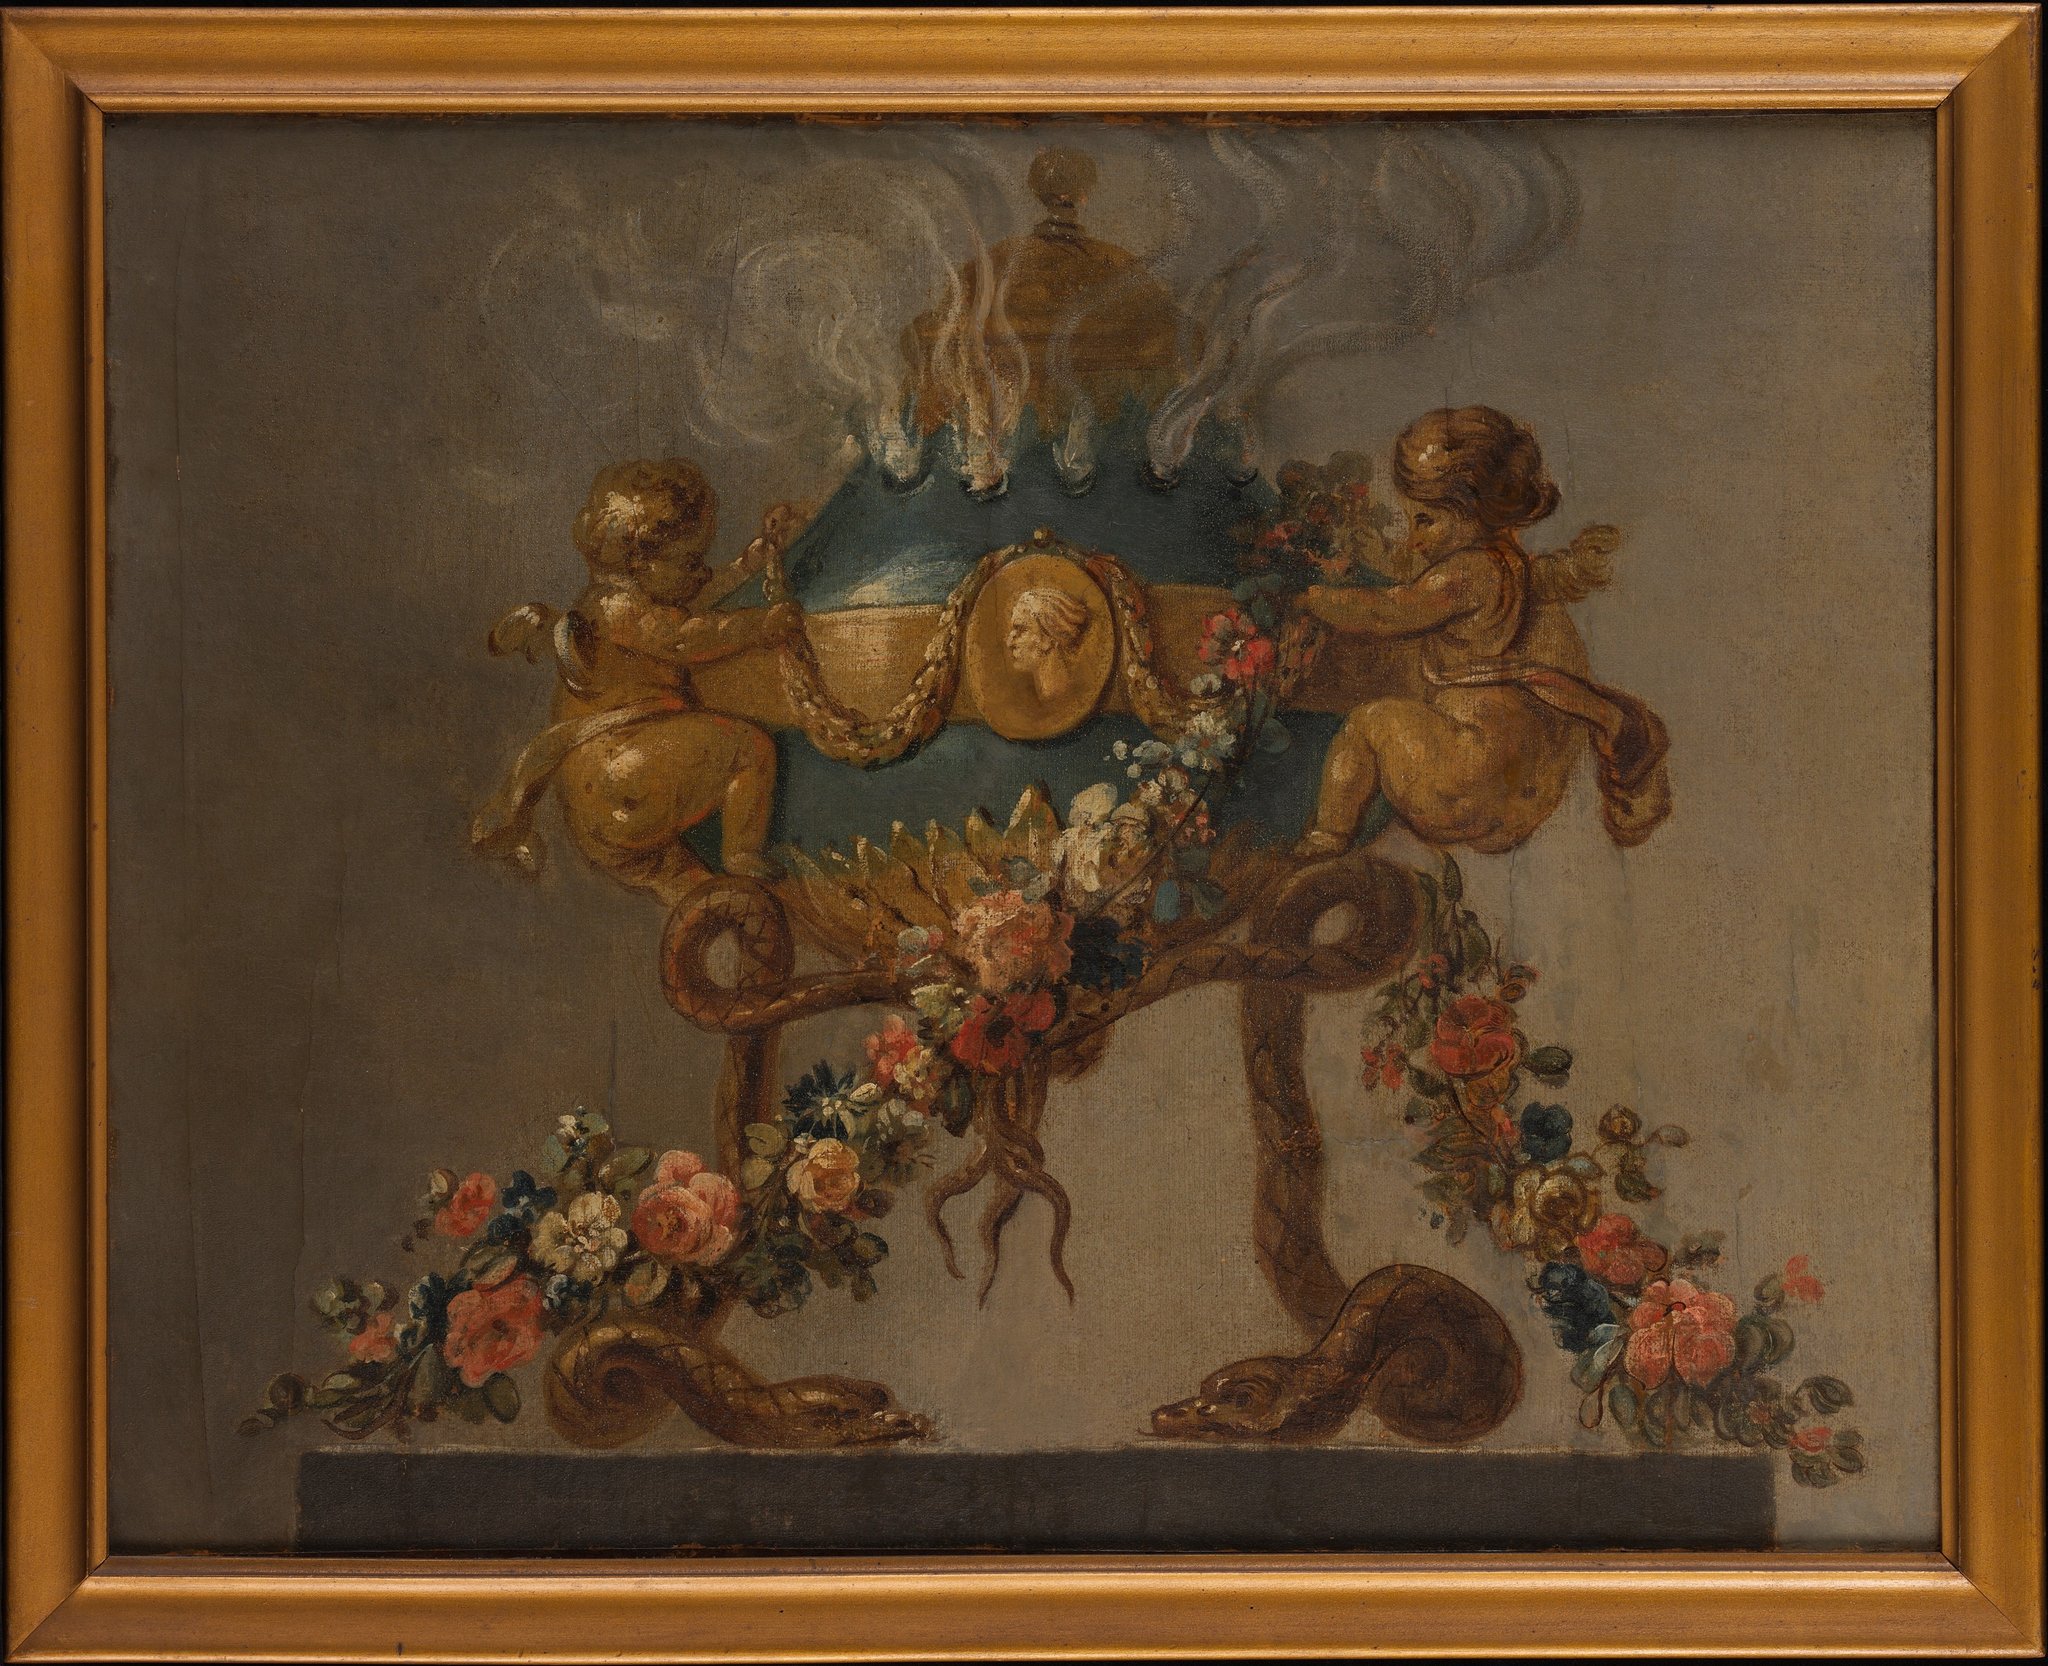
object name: overdoor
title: Perfume-burner supported by amorini and serpents and garlanded with flowers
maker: french painter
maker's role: artist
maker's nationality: french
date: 1701-1800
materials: canvas, oil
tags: garlands,putti,serpents